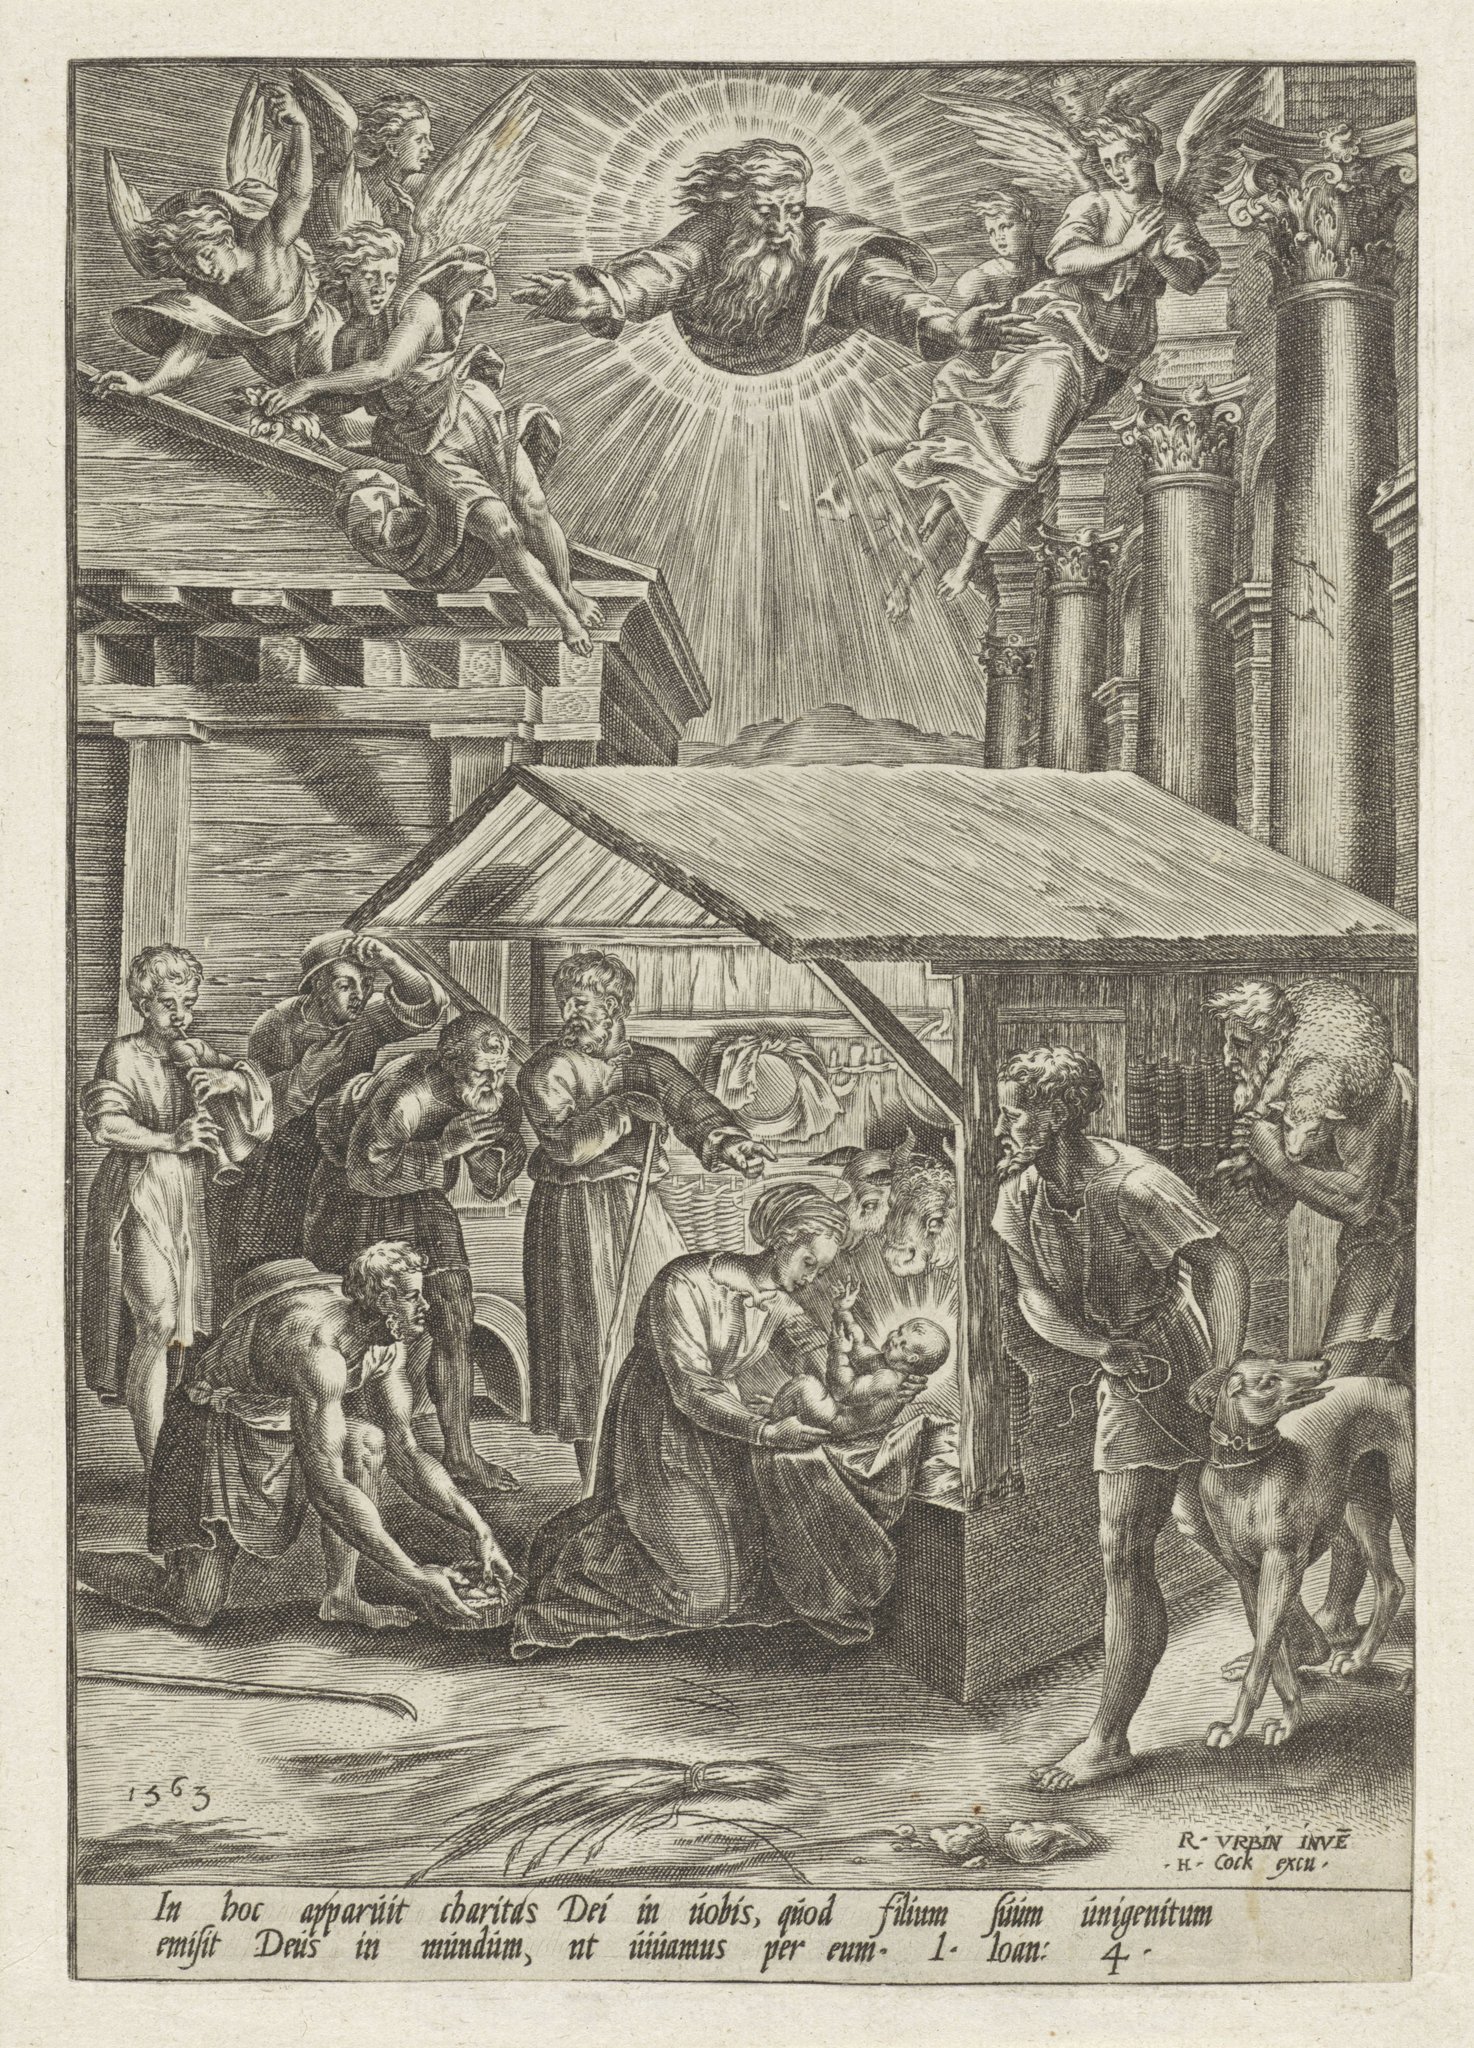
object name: print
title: Aanbidding der herders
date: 1563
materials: paper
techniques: engraving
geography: low countries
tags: adoration of the christ-child by the shepherds; mary and joseph present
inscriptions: collector's mark: Lugt 240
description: Enkele herders buigen en knielen bij Maria, die het Christuskind vasthoudt. Jozef wijst naar het Christuskind. In de stal staan de ezel en de os. Rechts komen nog twee herders aangelopen. Achter de stal nog een gebouw en enkele zuilen. In de lucht God omgeven door engelen. Onder een tweeregelig onderschrift in het Latijn uit 1 Joh. 4.